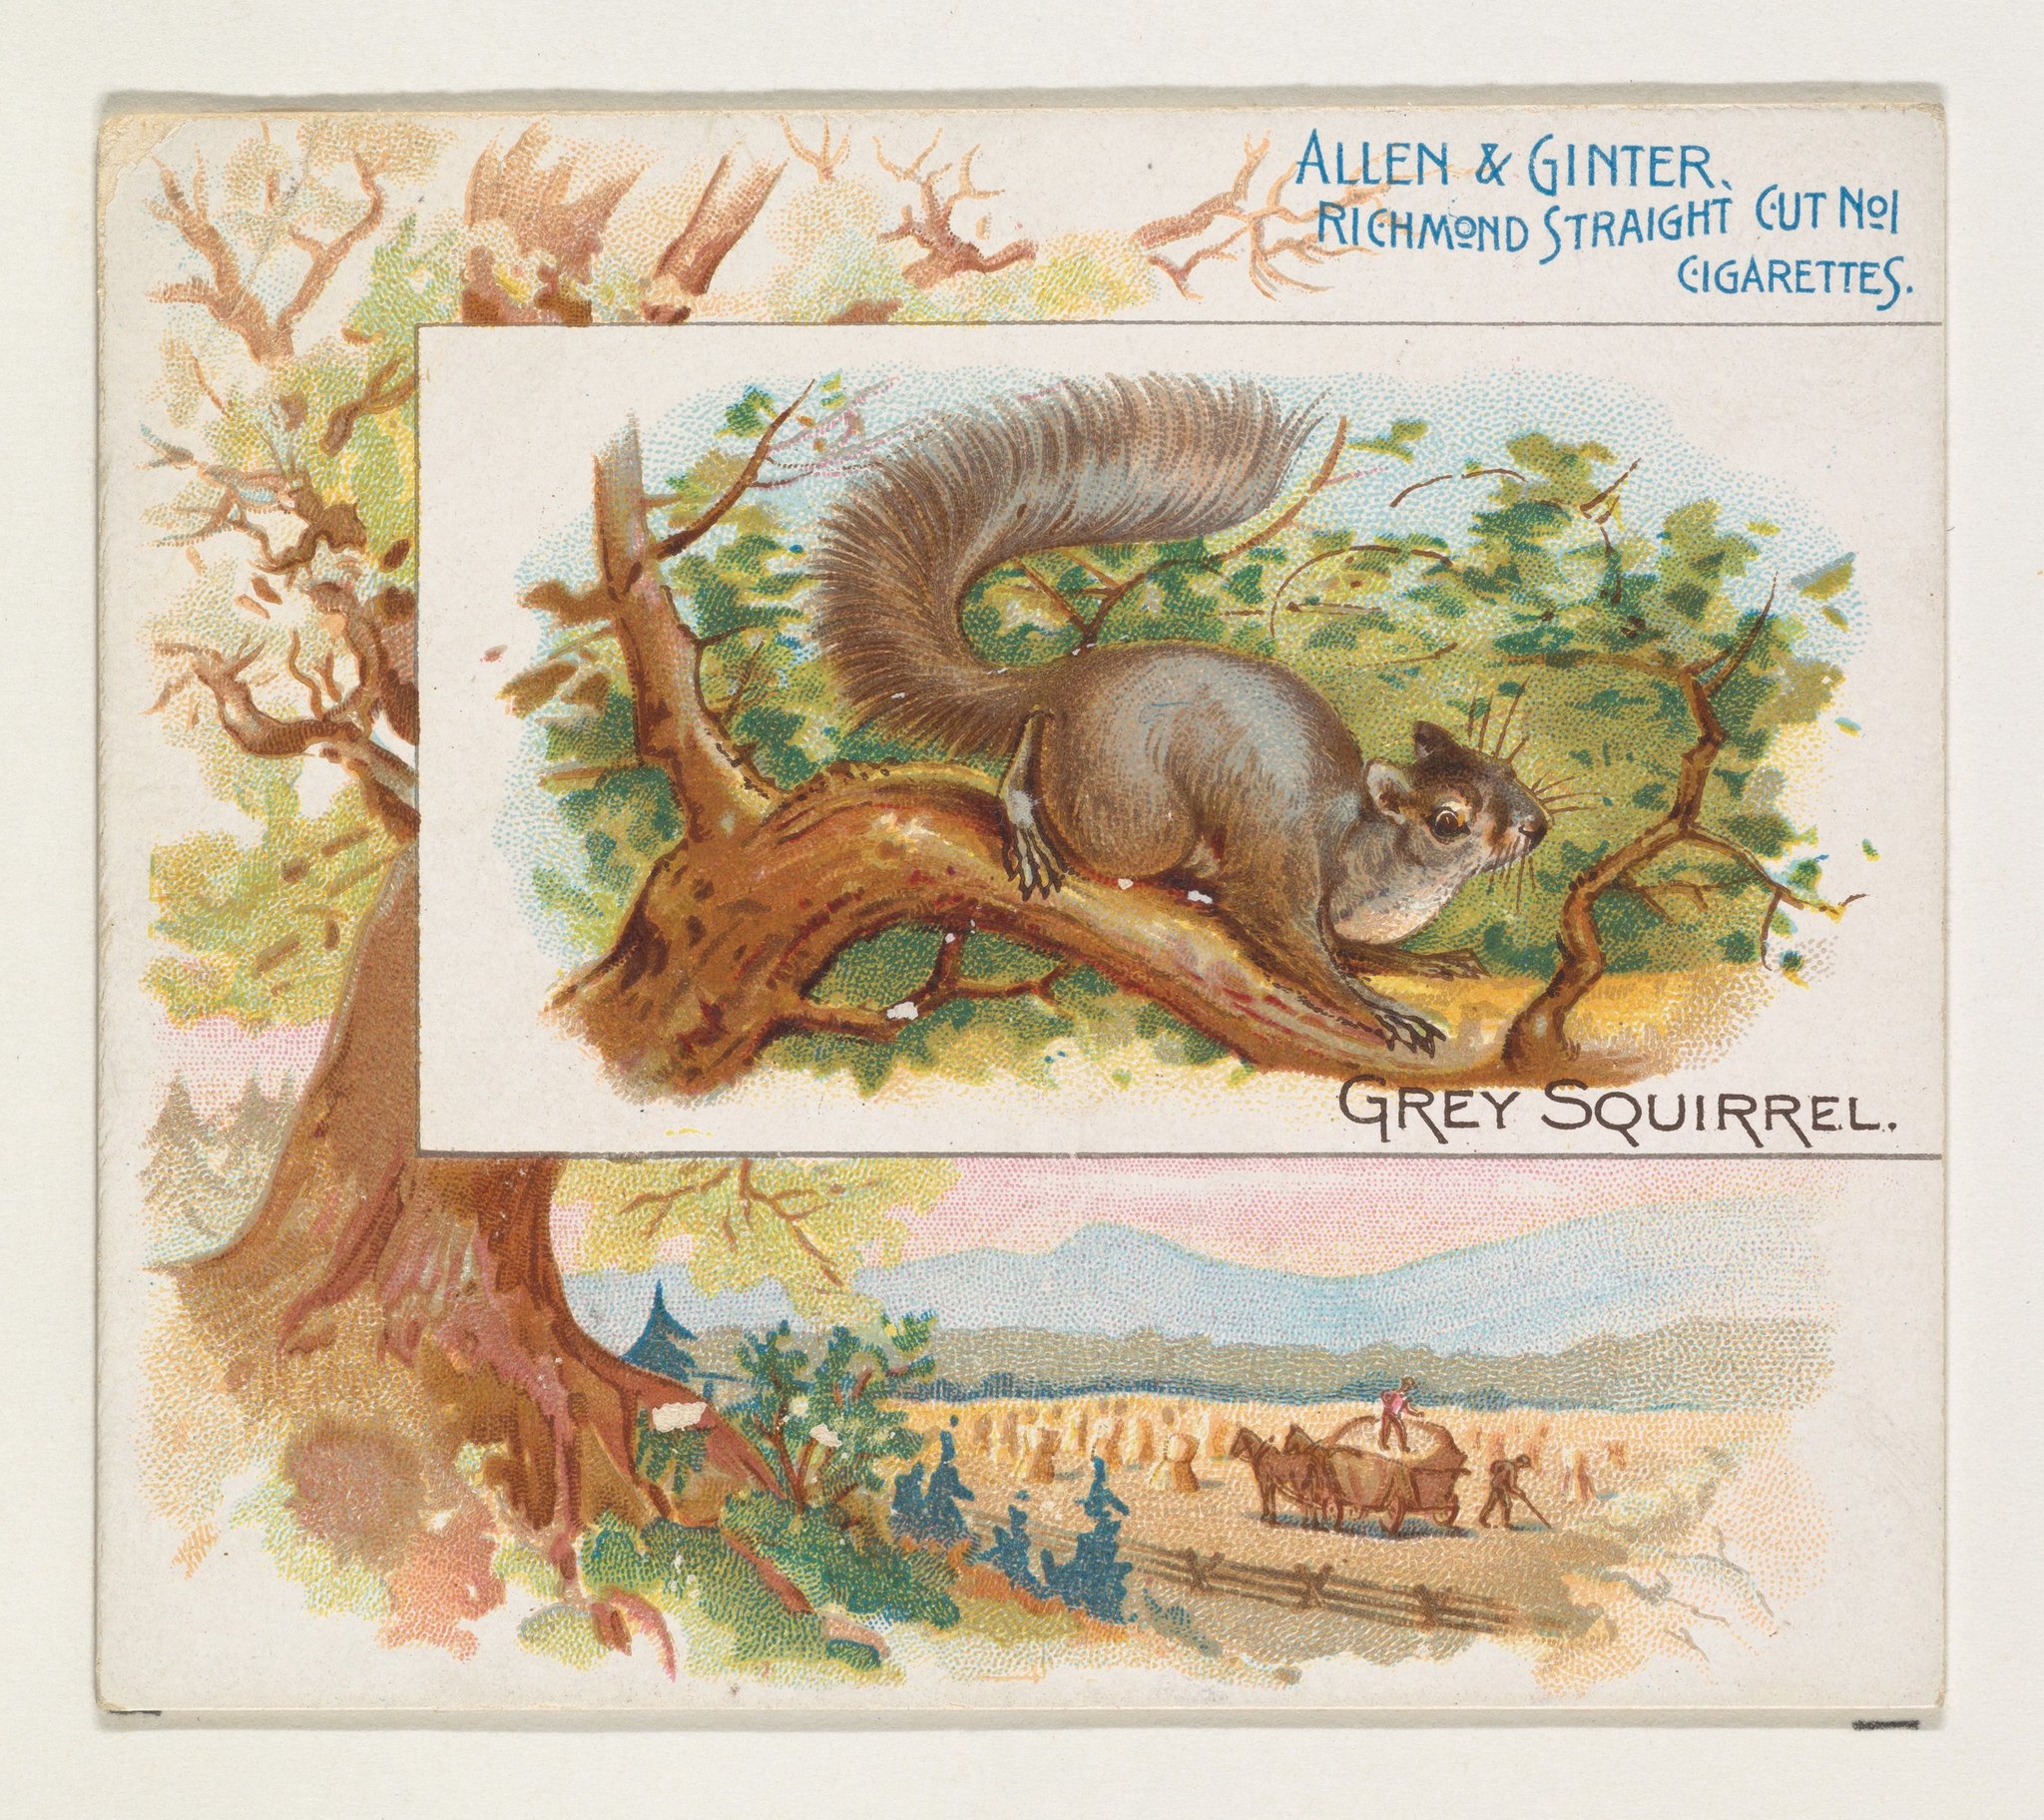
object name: print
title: Grey Squirrel, from Quadrupeds series (N41) for Allen & Ginter Cigarettes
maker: allen & ginter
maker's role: publisher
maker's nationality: american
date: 1890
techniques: color lithograph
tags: squirrels